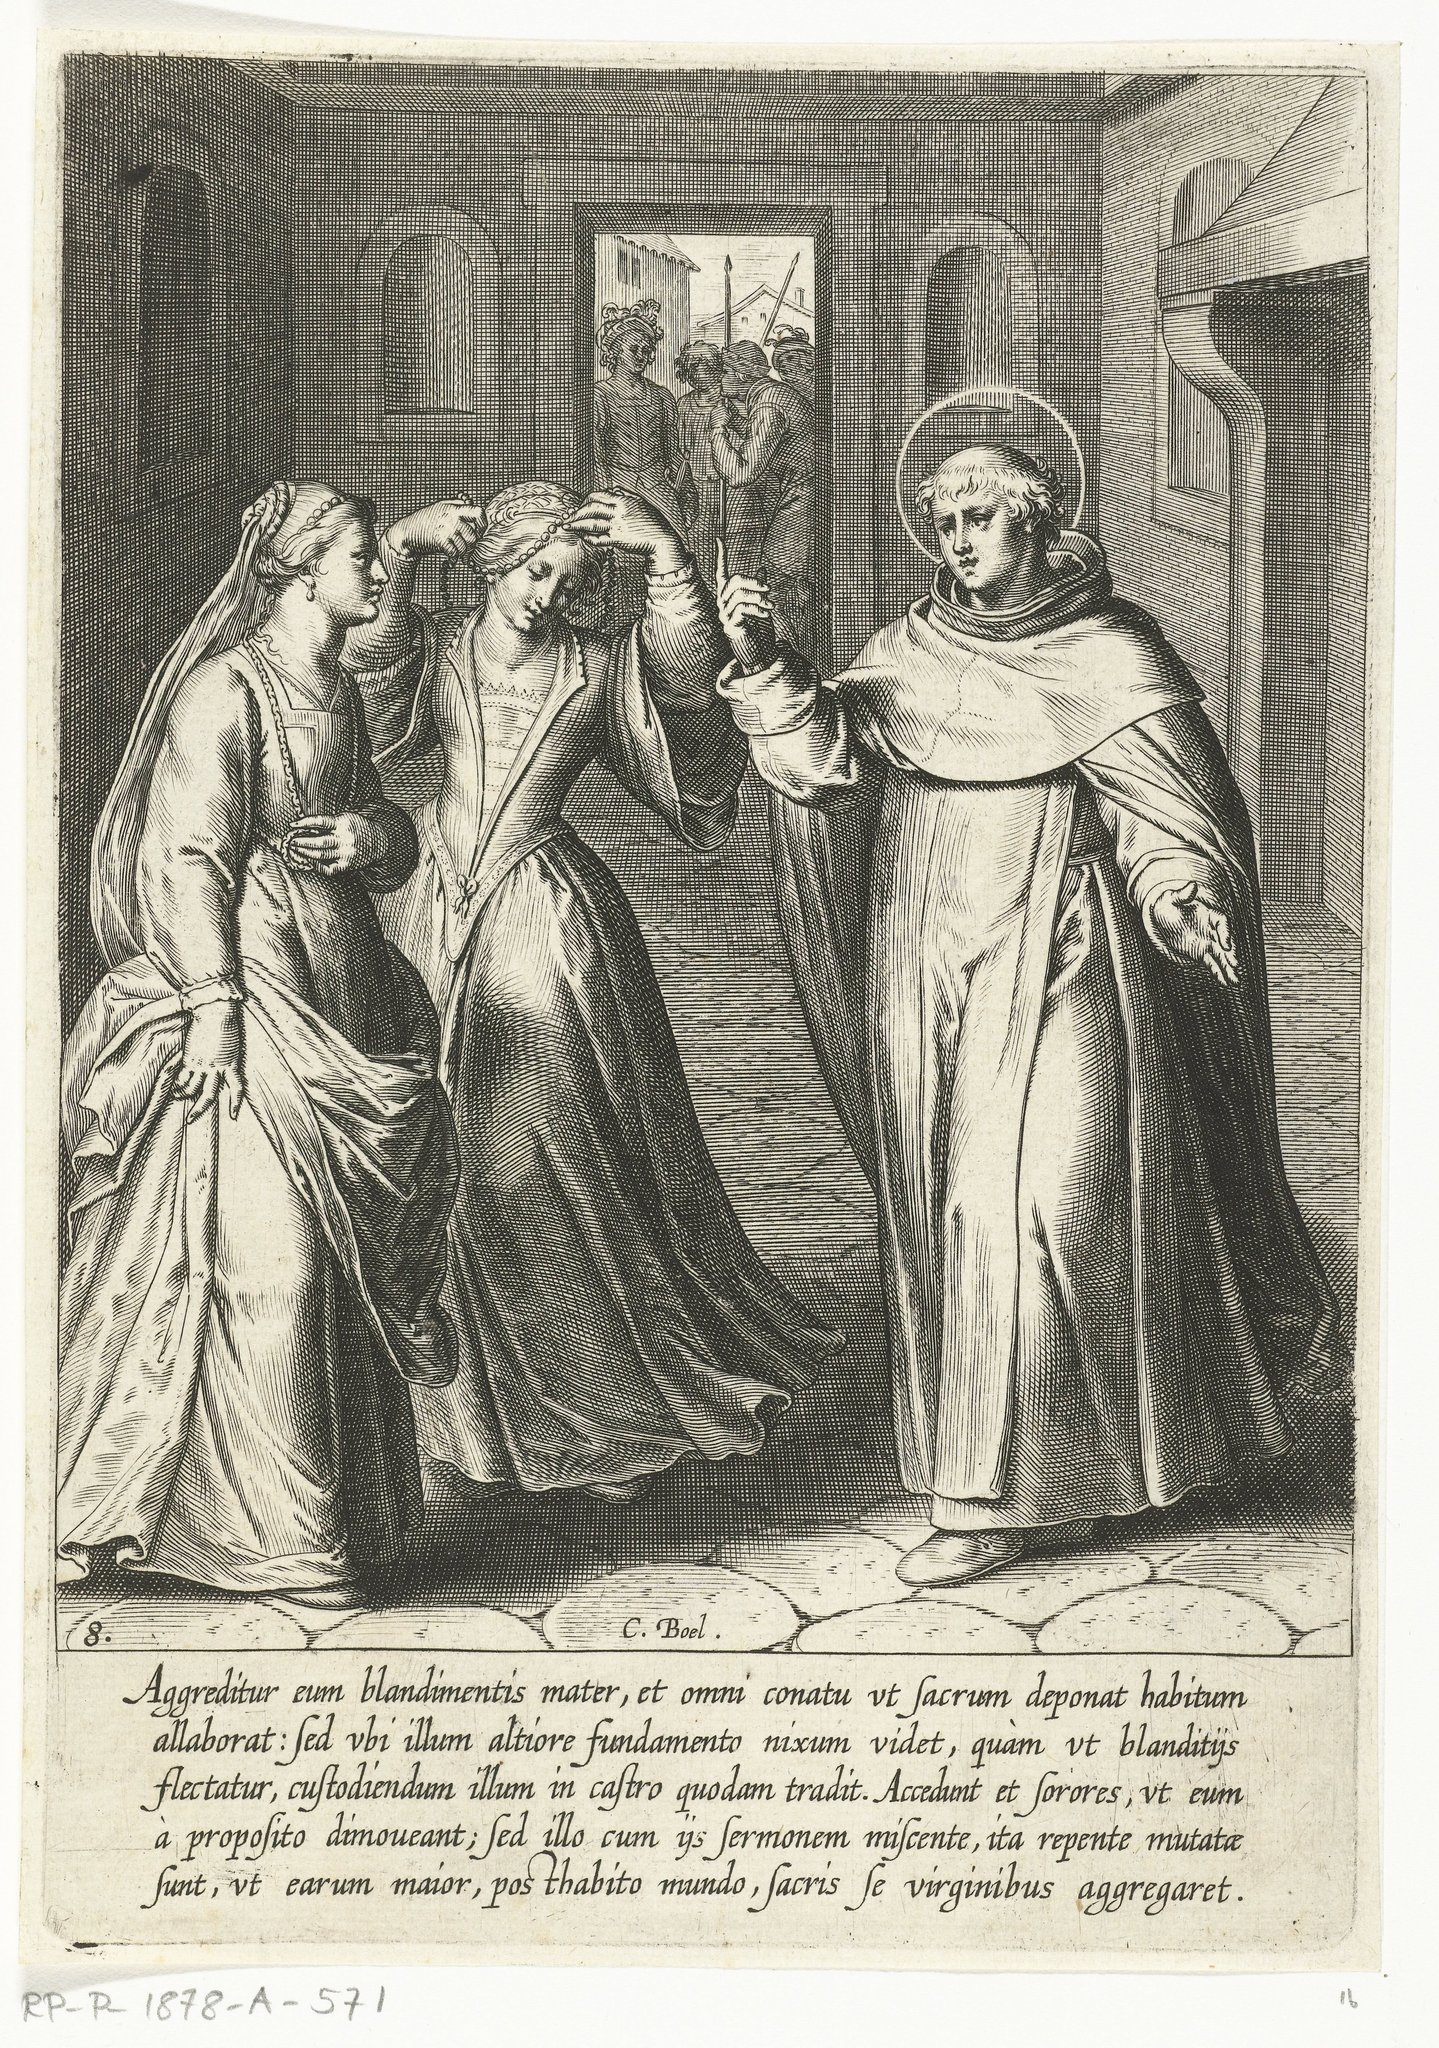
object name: print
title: Thomas bekeert zijn zus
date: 1610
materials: paper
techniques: engraving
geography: antwerp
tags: thomas van aquino, the dominican theologian, 'angelic doctor' thomas of aquino; possible attributes: book, (chain with) sun, dove, girdle of chastity, lily, model of church, monstrance (or chalice), mitre (under feet), star (on breast)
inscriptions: collector's mark: Lugt 2228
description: Thomas bekeerd zijn oudste zus. Zij legt haar sieraden af en gaat het klooster in. Prent uit een serie van 30 prenten die het levensverhaal van Thomas van Aquino verbeelden. De prenten, naar ontwerp van en uitgegeven door Otto van Veen, zijn door C. Boel, E. van Paenderen, C. Galle en G. Swanenburgh vervaardigd.